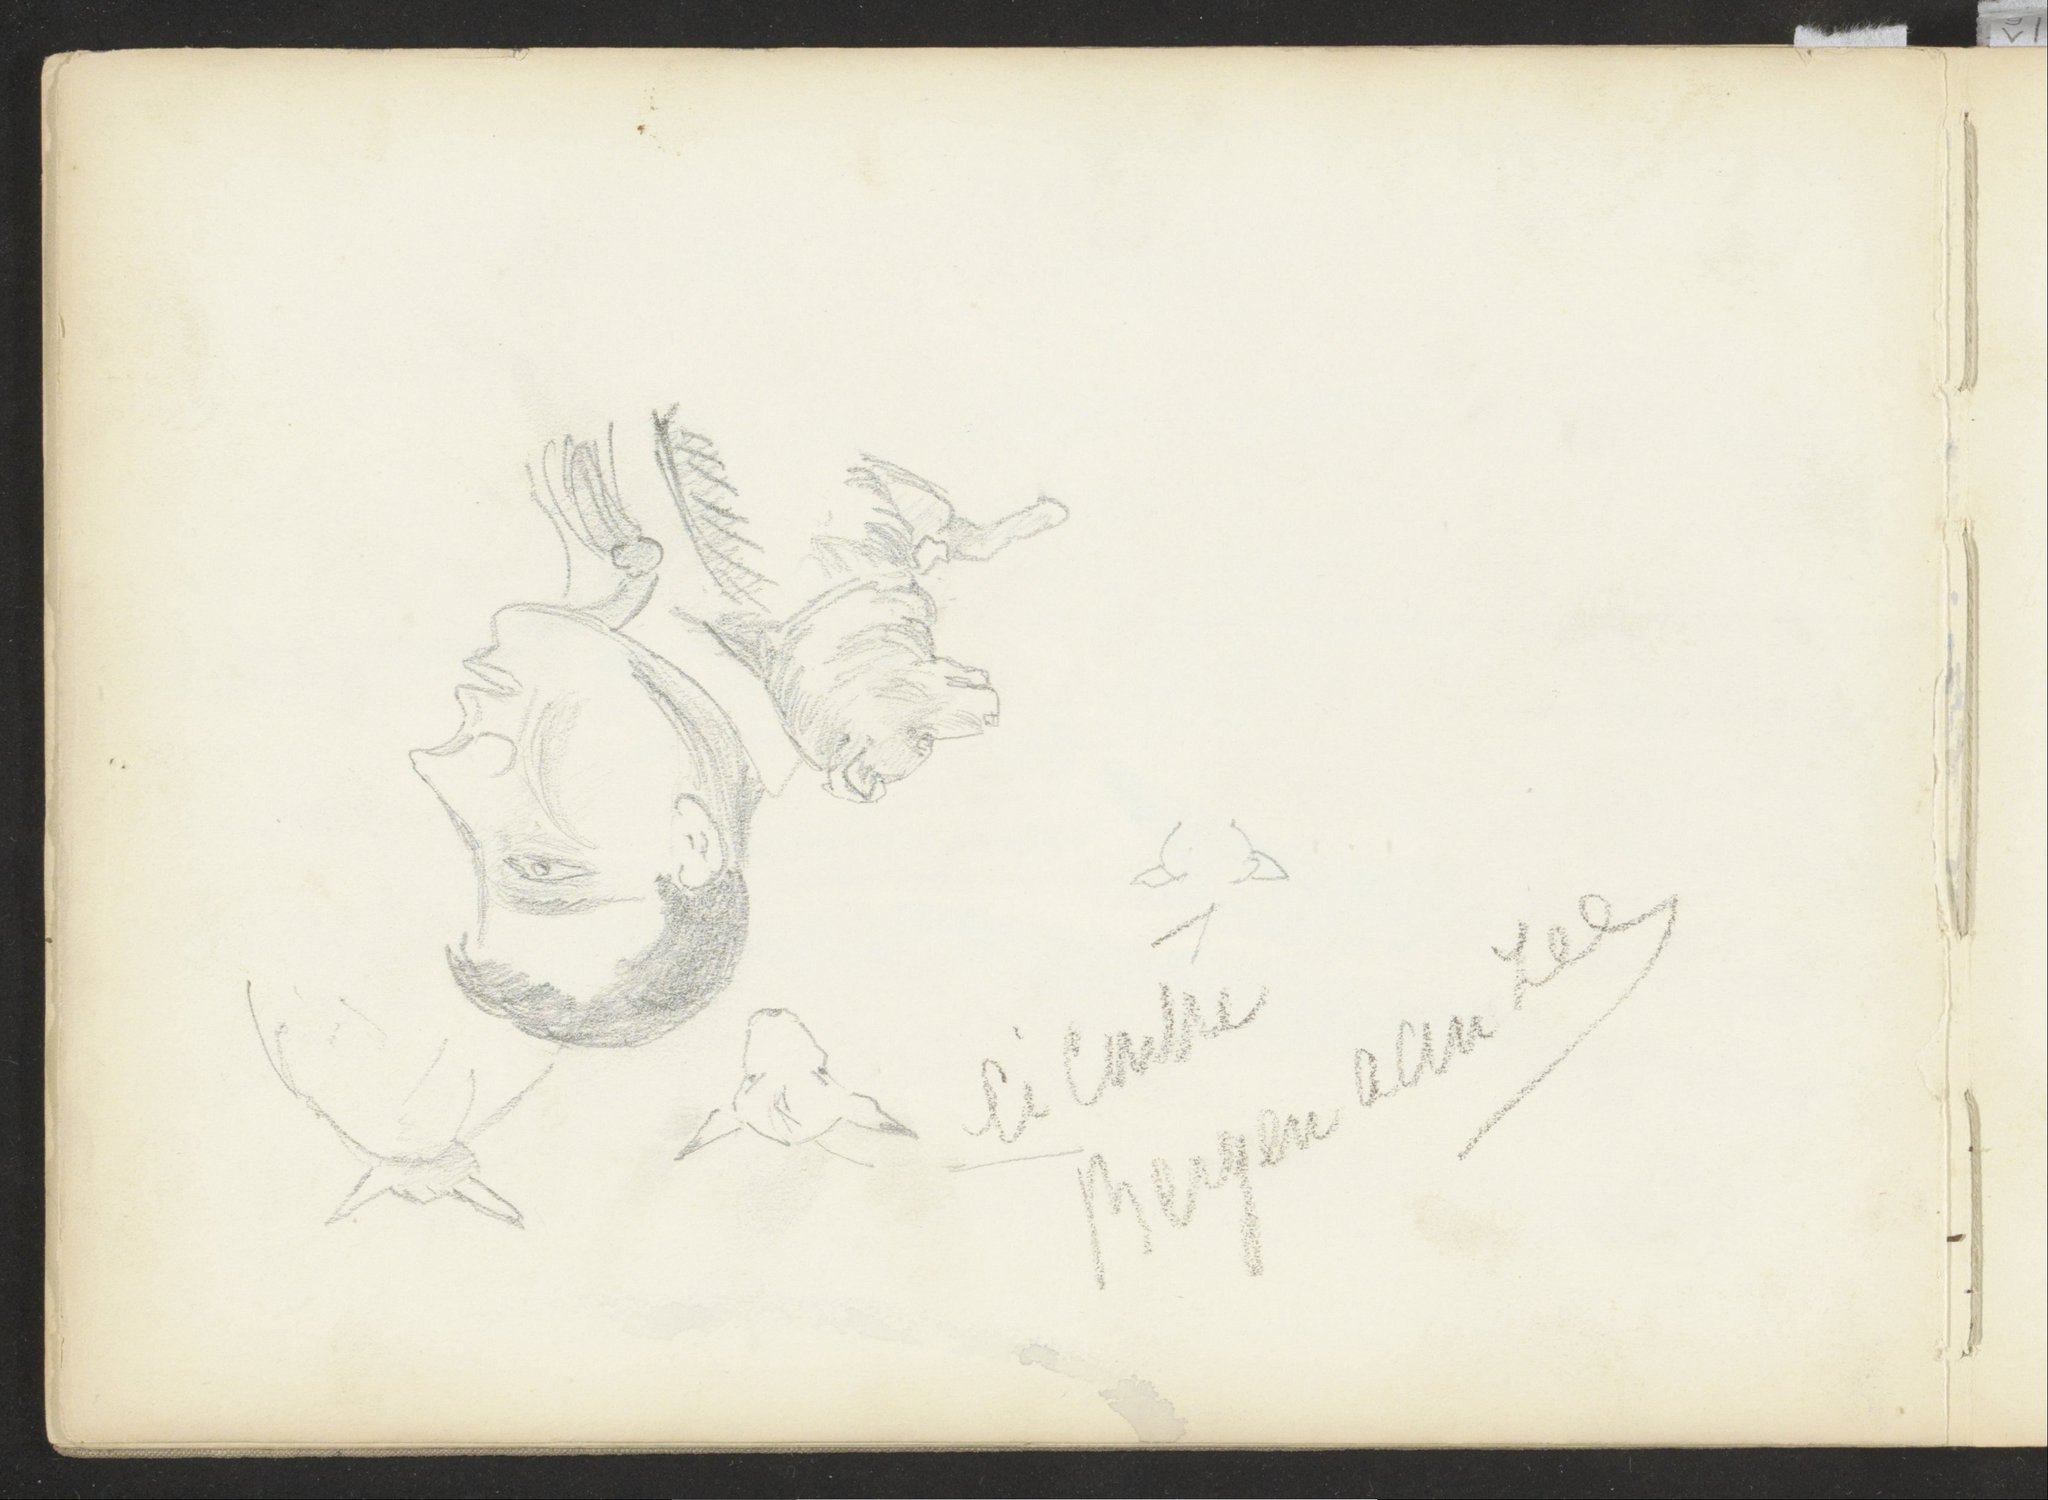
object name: sketchbook leaf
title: Schapen, een hond en een karikatuur van een man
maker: jonkheer johannes ludovicus paulus bosch van drakestein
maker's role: draughtsman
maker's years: 1865-1929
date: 1913-1916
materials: paper, pencil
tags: caricatures (human types), sheep, dog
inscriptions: annotation: ‘Le cadre/ Bergen aan Zee’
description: Blad 7 verso uit een schetsboek met 47 bladen.